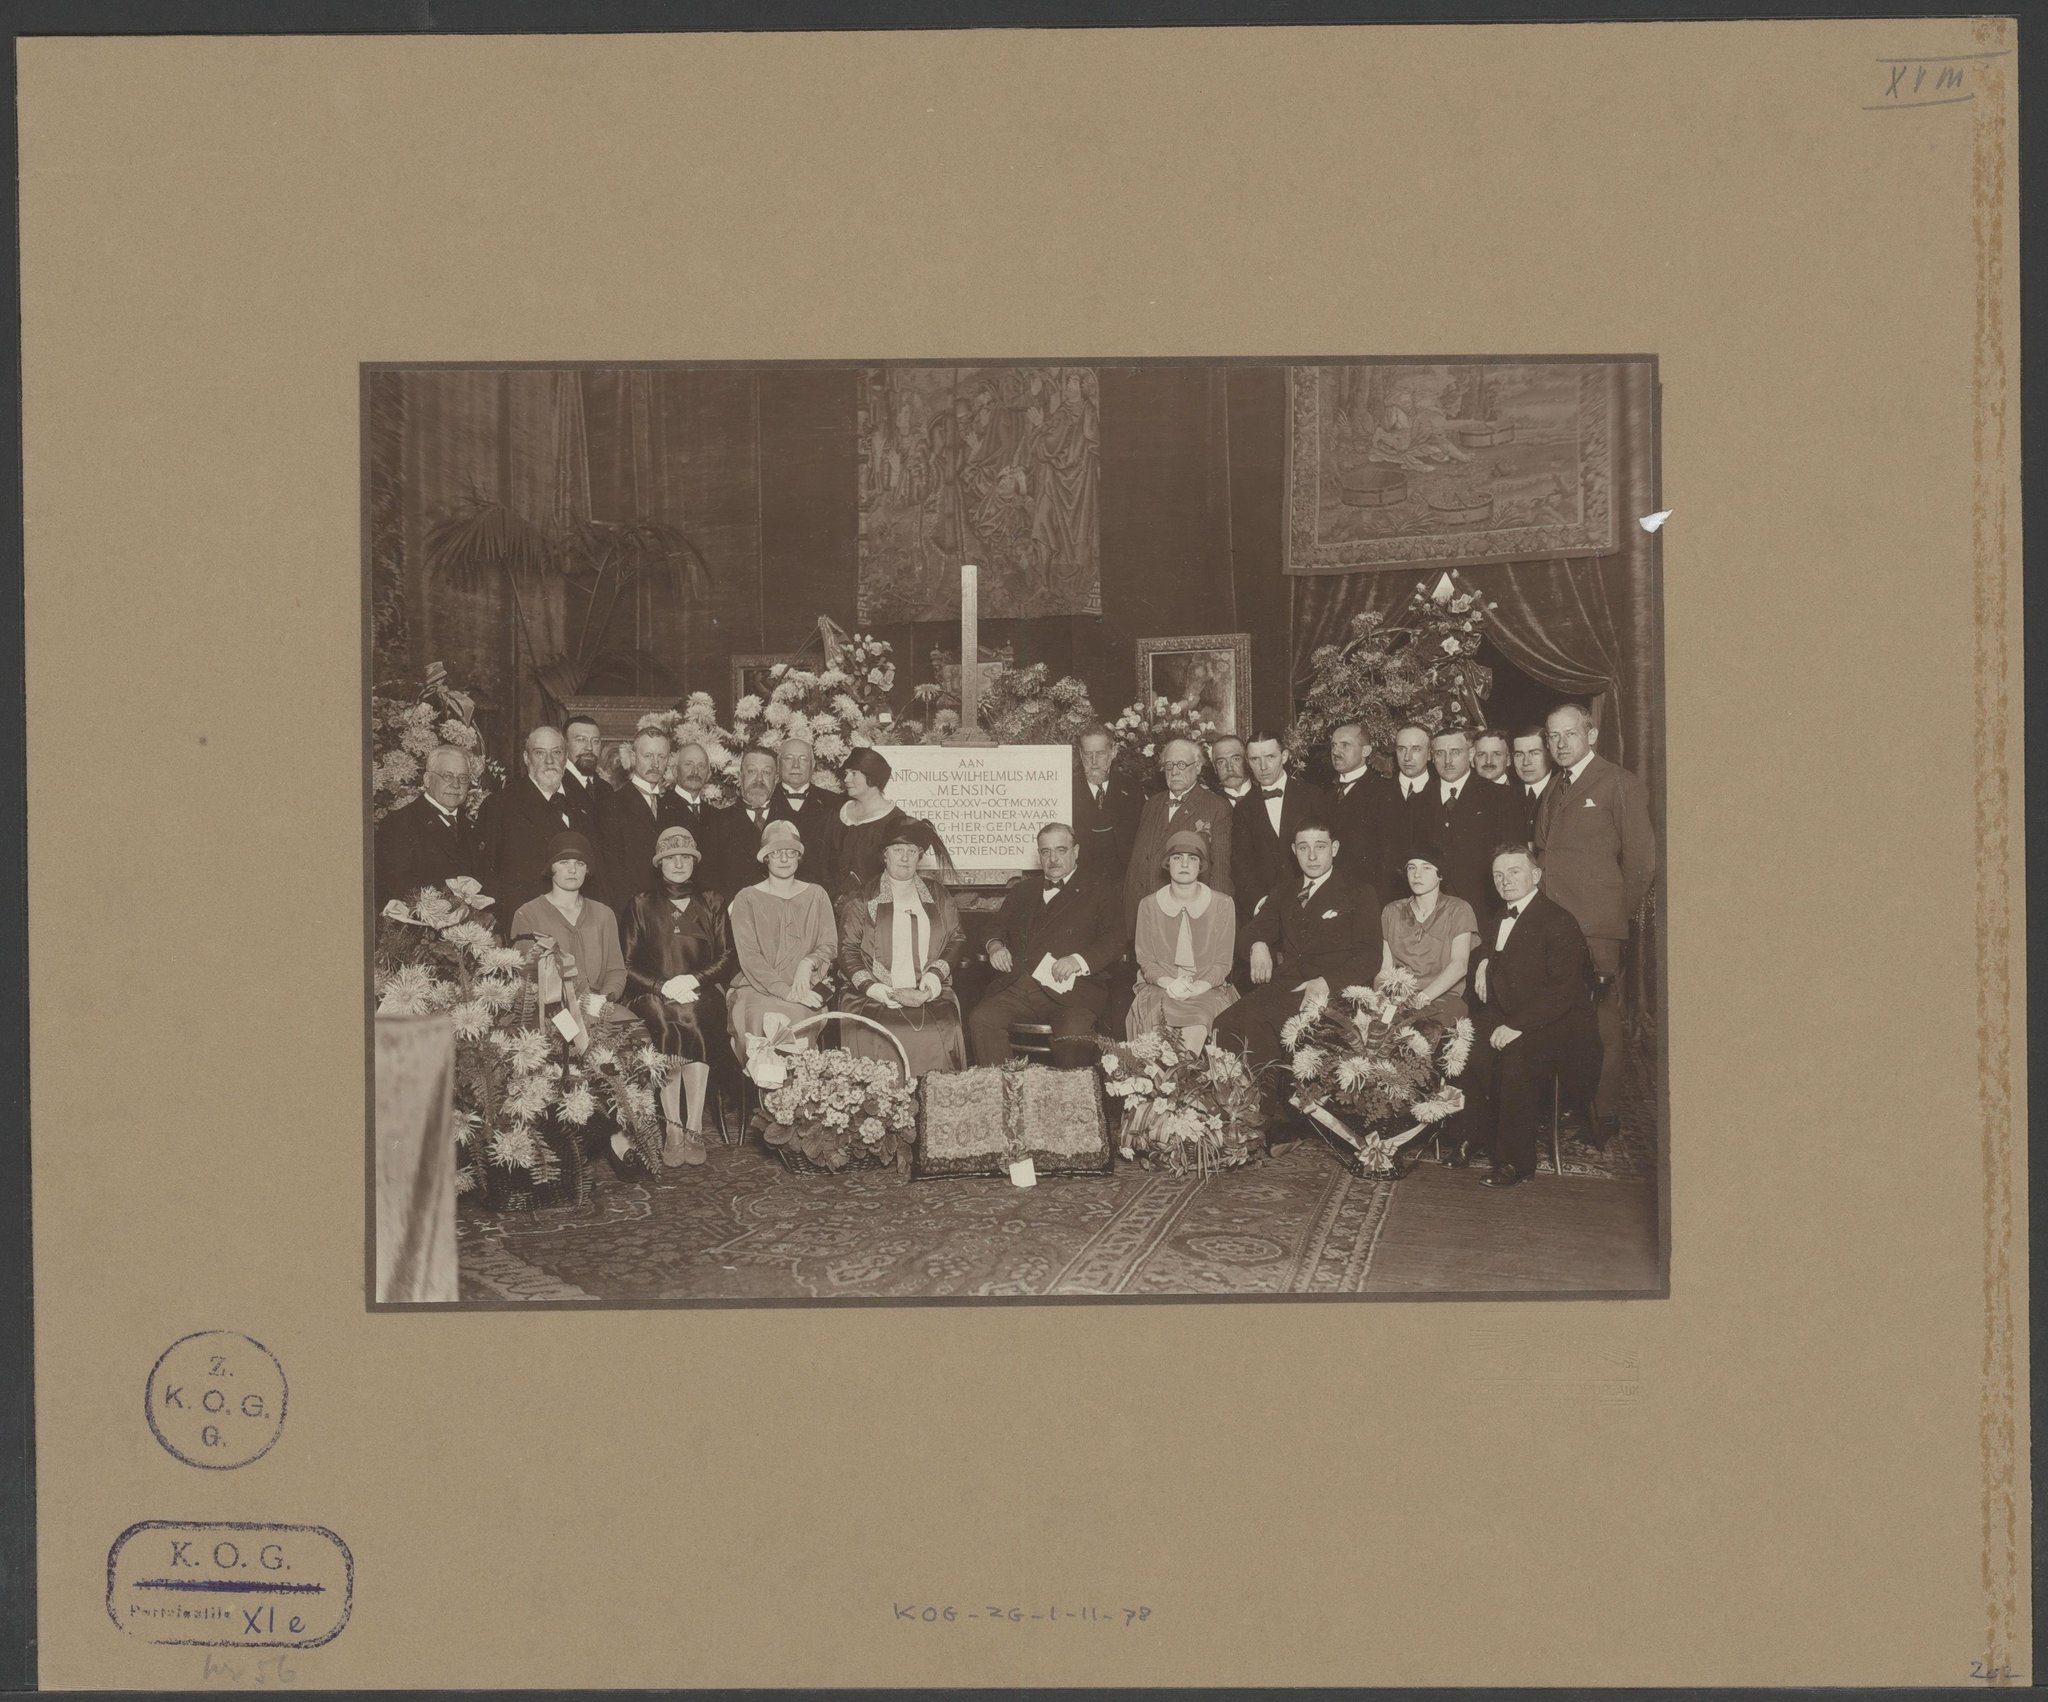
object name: photograph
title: Groepsfoto in het veilinghuis van Antonius Wilhelmus Mari Mensing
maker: Anonymous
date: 1925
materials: paper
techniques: albumen print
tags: antonius wilhelmus mari mensing, historical persons, amsterdam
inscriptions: stamp: Lugt 1641b, collector's mark: Lugt 1641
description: Onderwerpsrubrieken binnen de Atlas Zeden en Gewoonten: Handel, nijverheid en verkeer, Koophandel, Veilingen, Makelaardij en Verzekeringswezen. Kamers te huur.